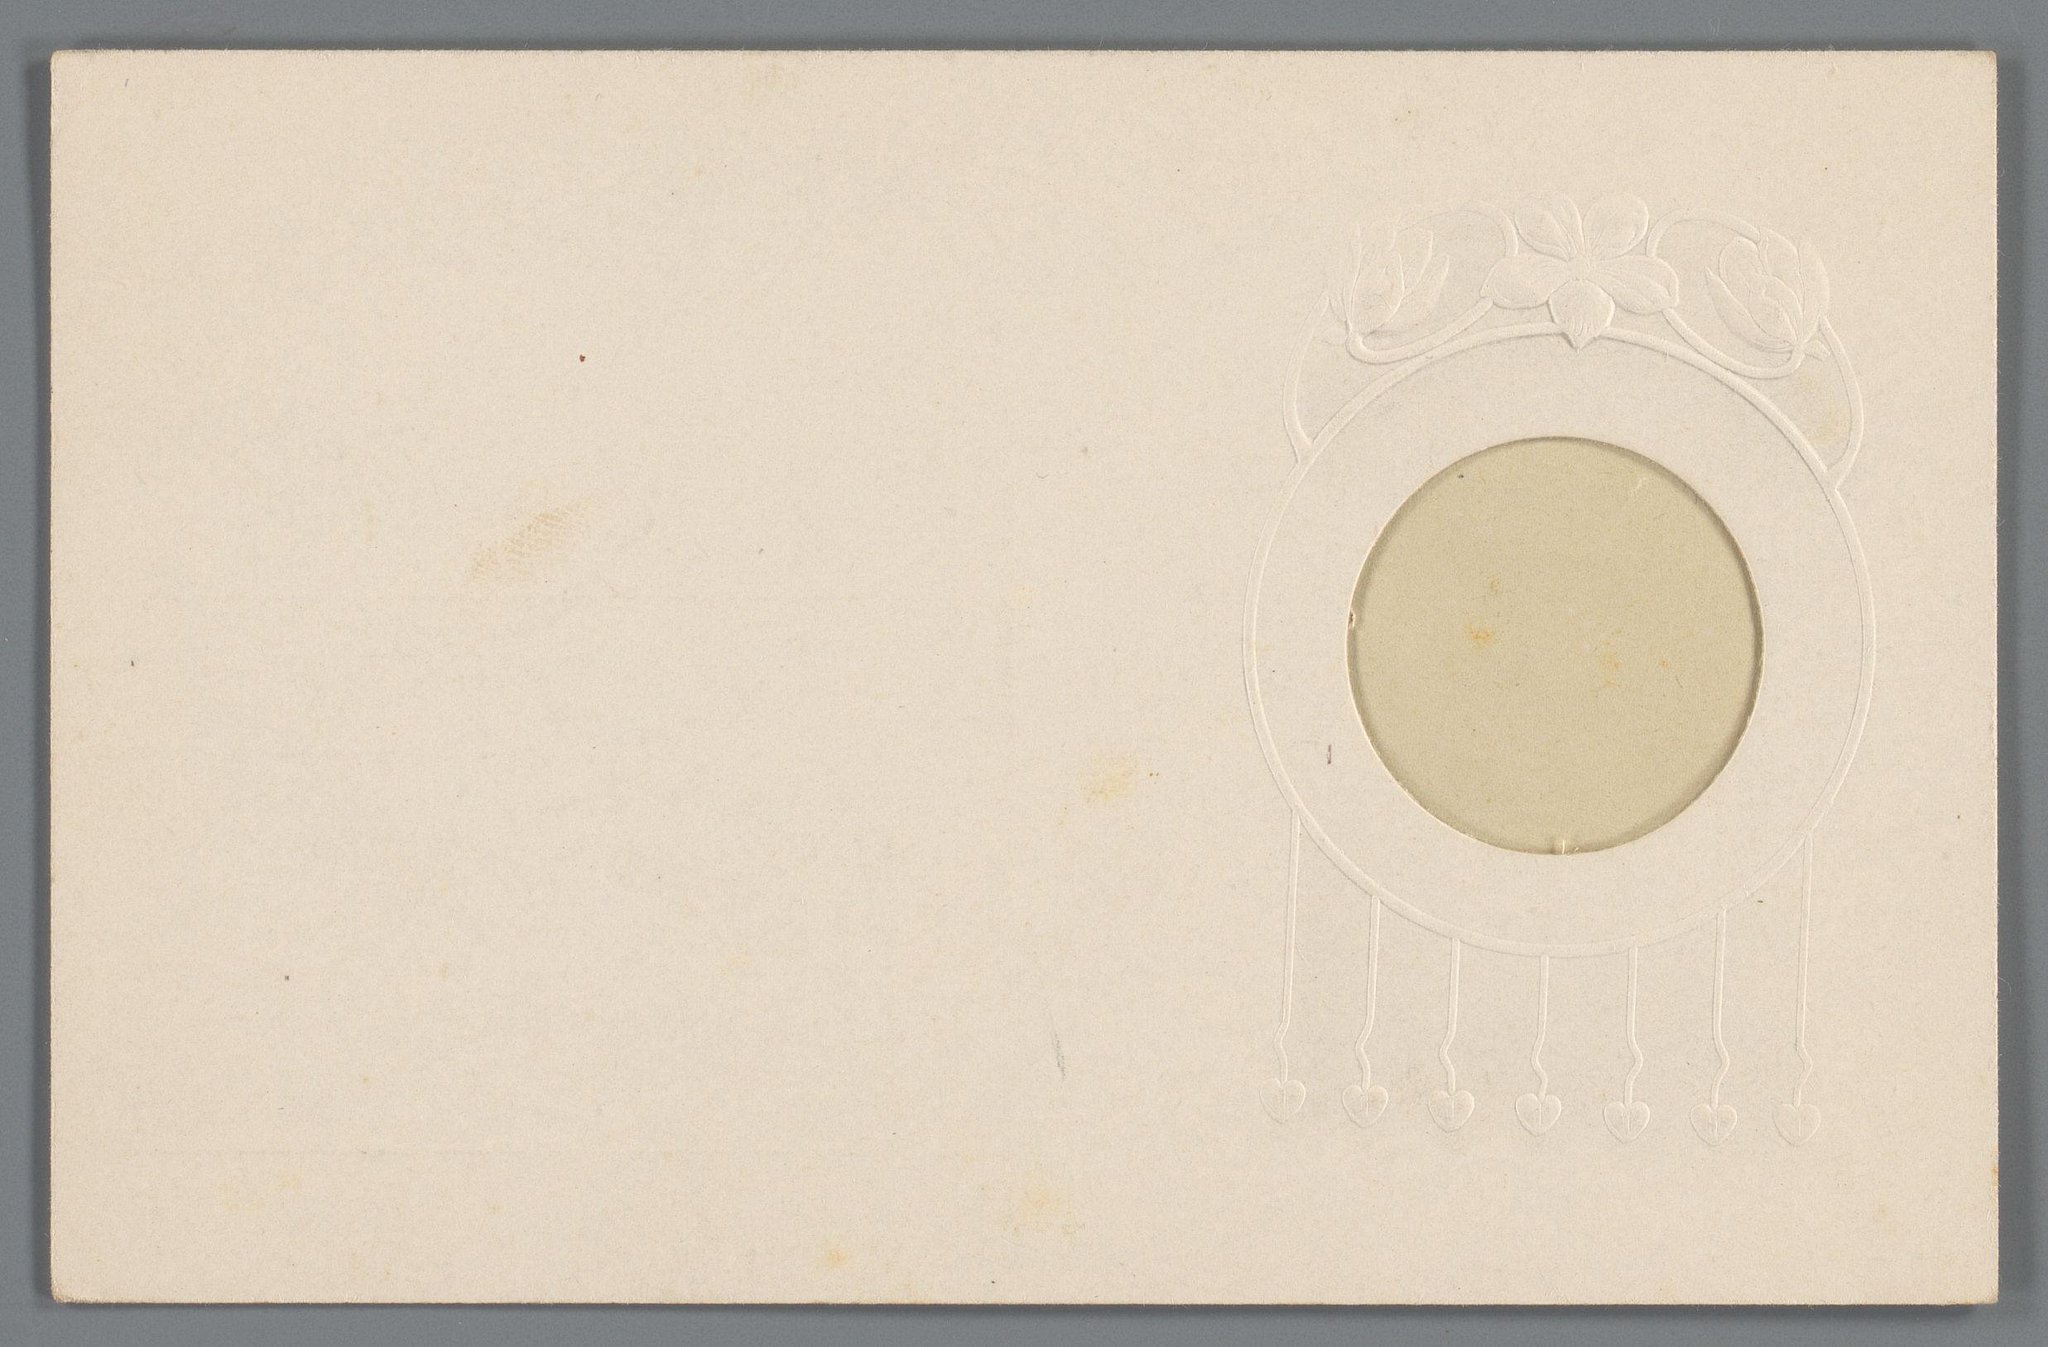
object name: ansichtkaart, prentbriefkaart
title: Decoratie met Jugendstilmotief en een uitsparing voor fotopapier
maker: Anonymous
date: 1905-1930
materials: cardboard, paper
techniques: albumen print, blind stamped